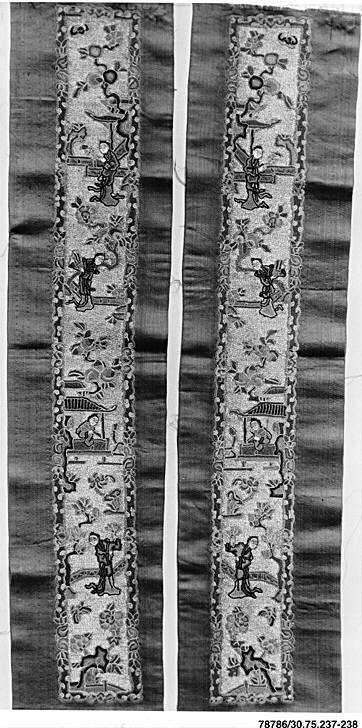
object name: sleeve band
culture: chinese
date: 1801-1900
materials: metal thread, silk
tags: human figures